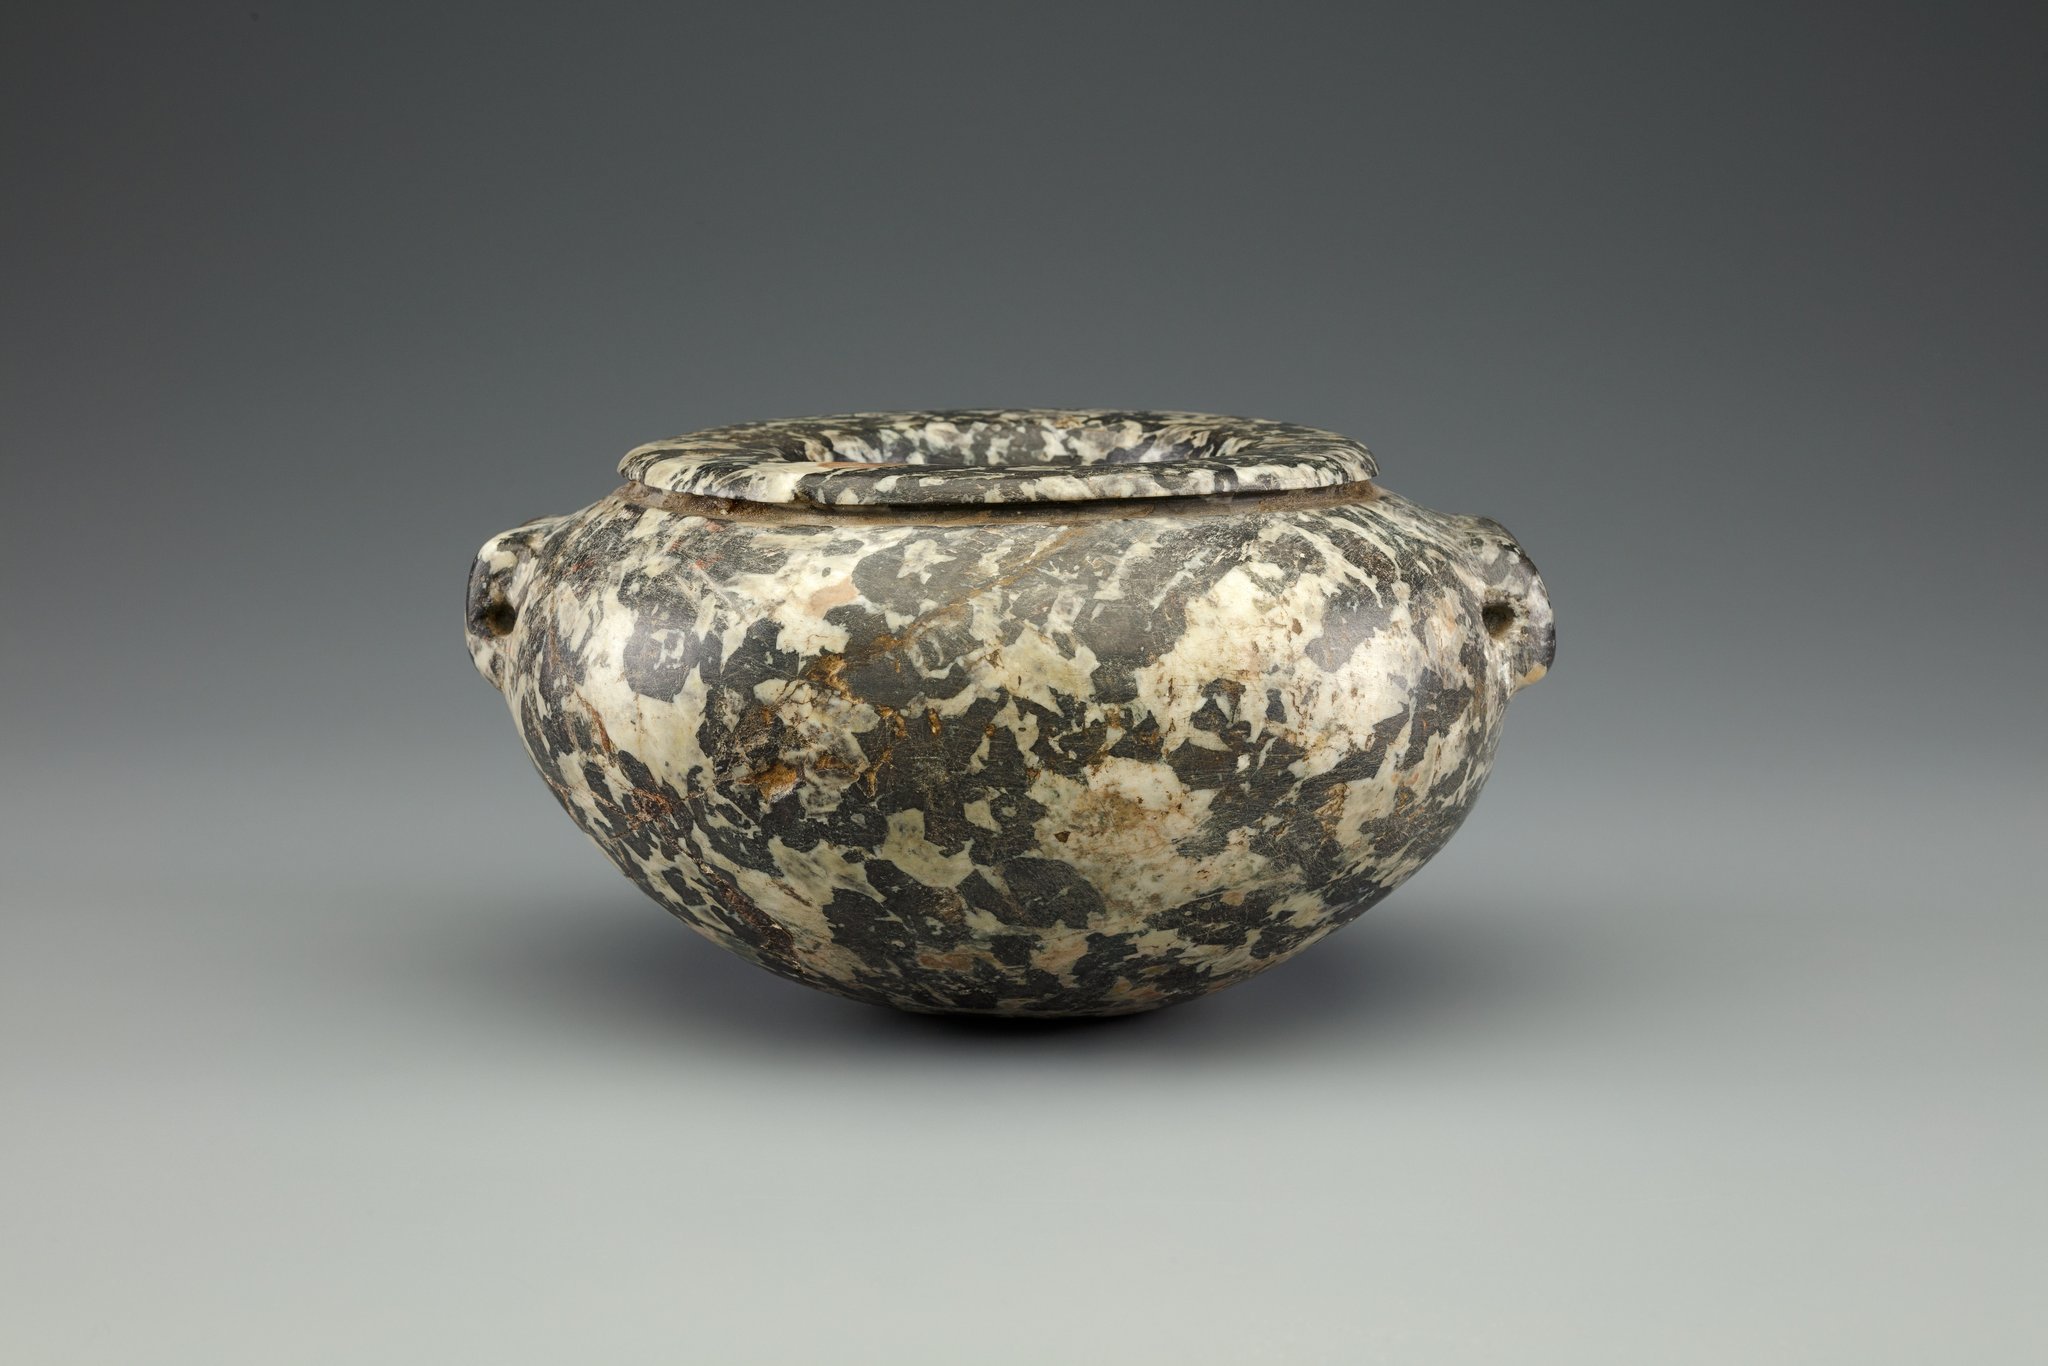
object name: jar, lug handle, squat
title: Squat jar with two lugs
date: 2649-2630 BCE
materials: quartz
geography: egypt